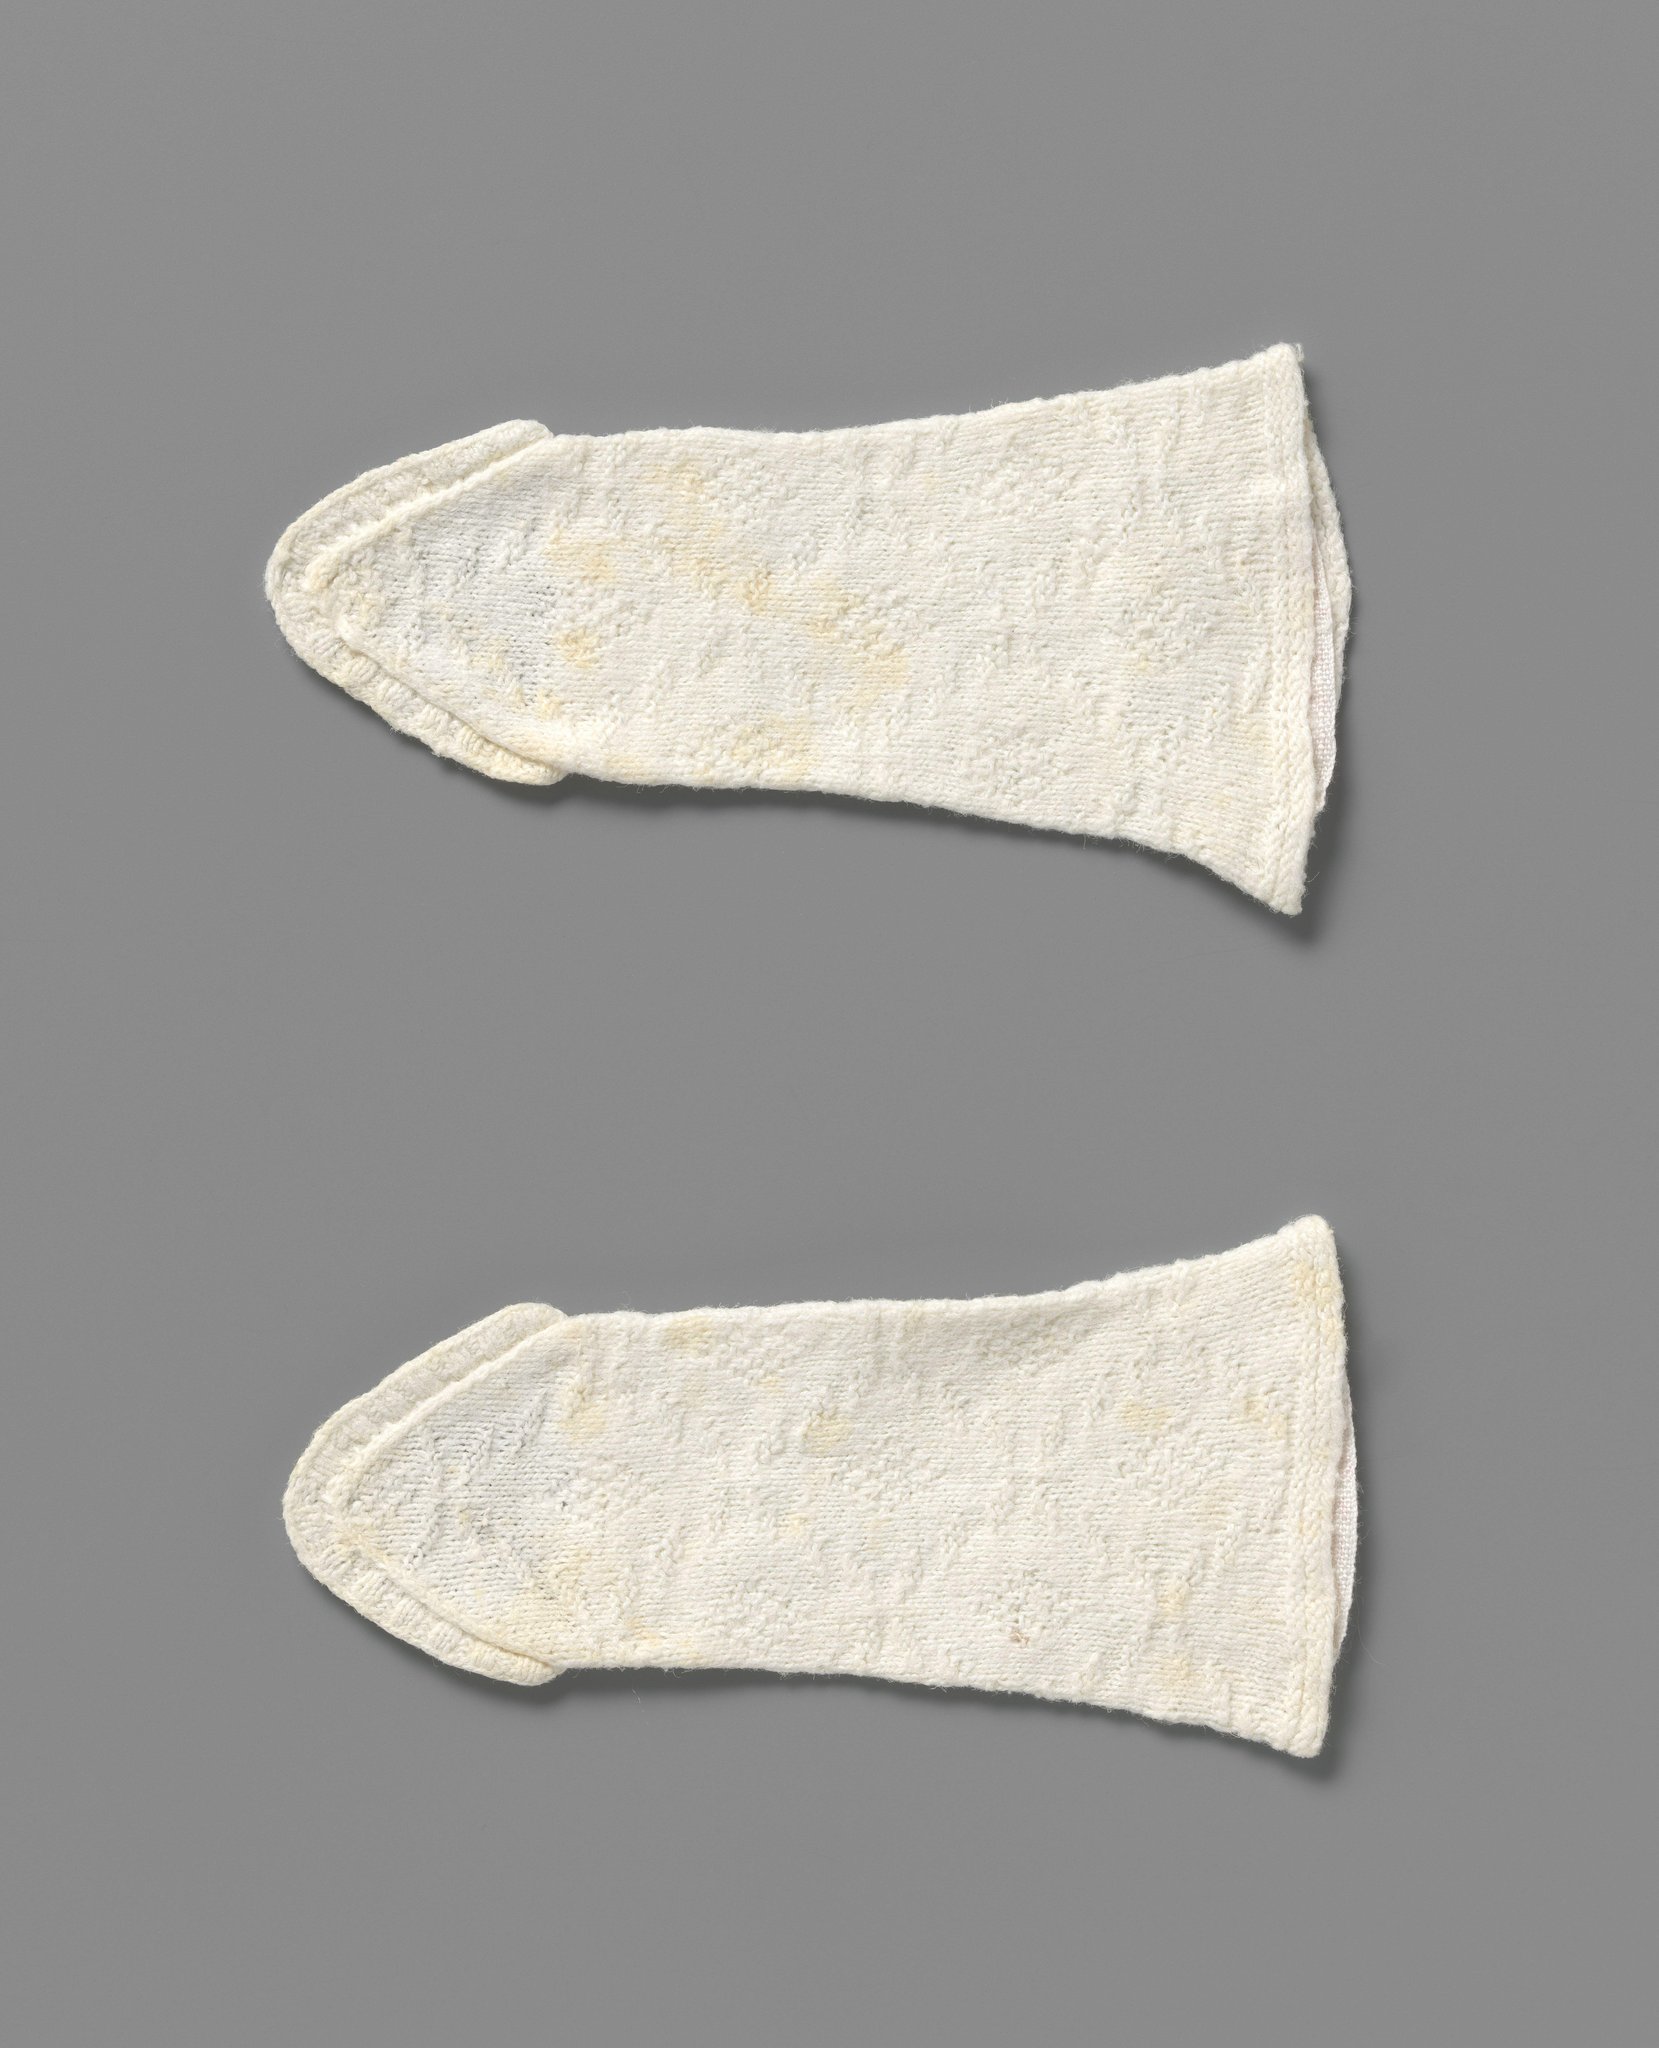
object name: mitt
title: Mitaine van witte gebreide katoen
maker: Anonymous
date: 1790-1820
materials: cotton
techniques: knitting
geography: zaanstreek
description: Mitaine van witte gebreide katoen, gebreid in een ruitpatroon met bloemen, voor baby of klein kind